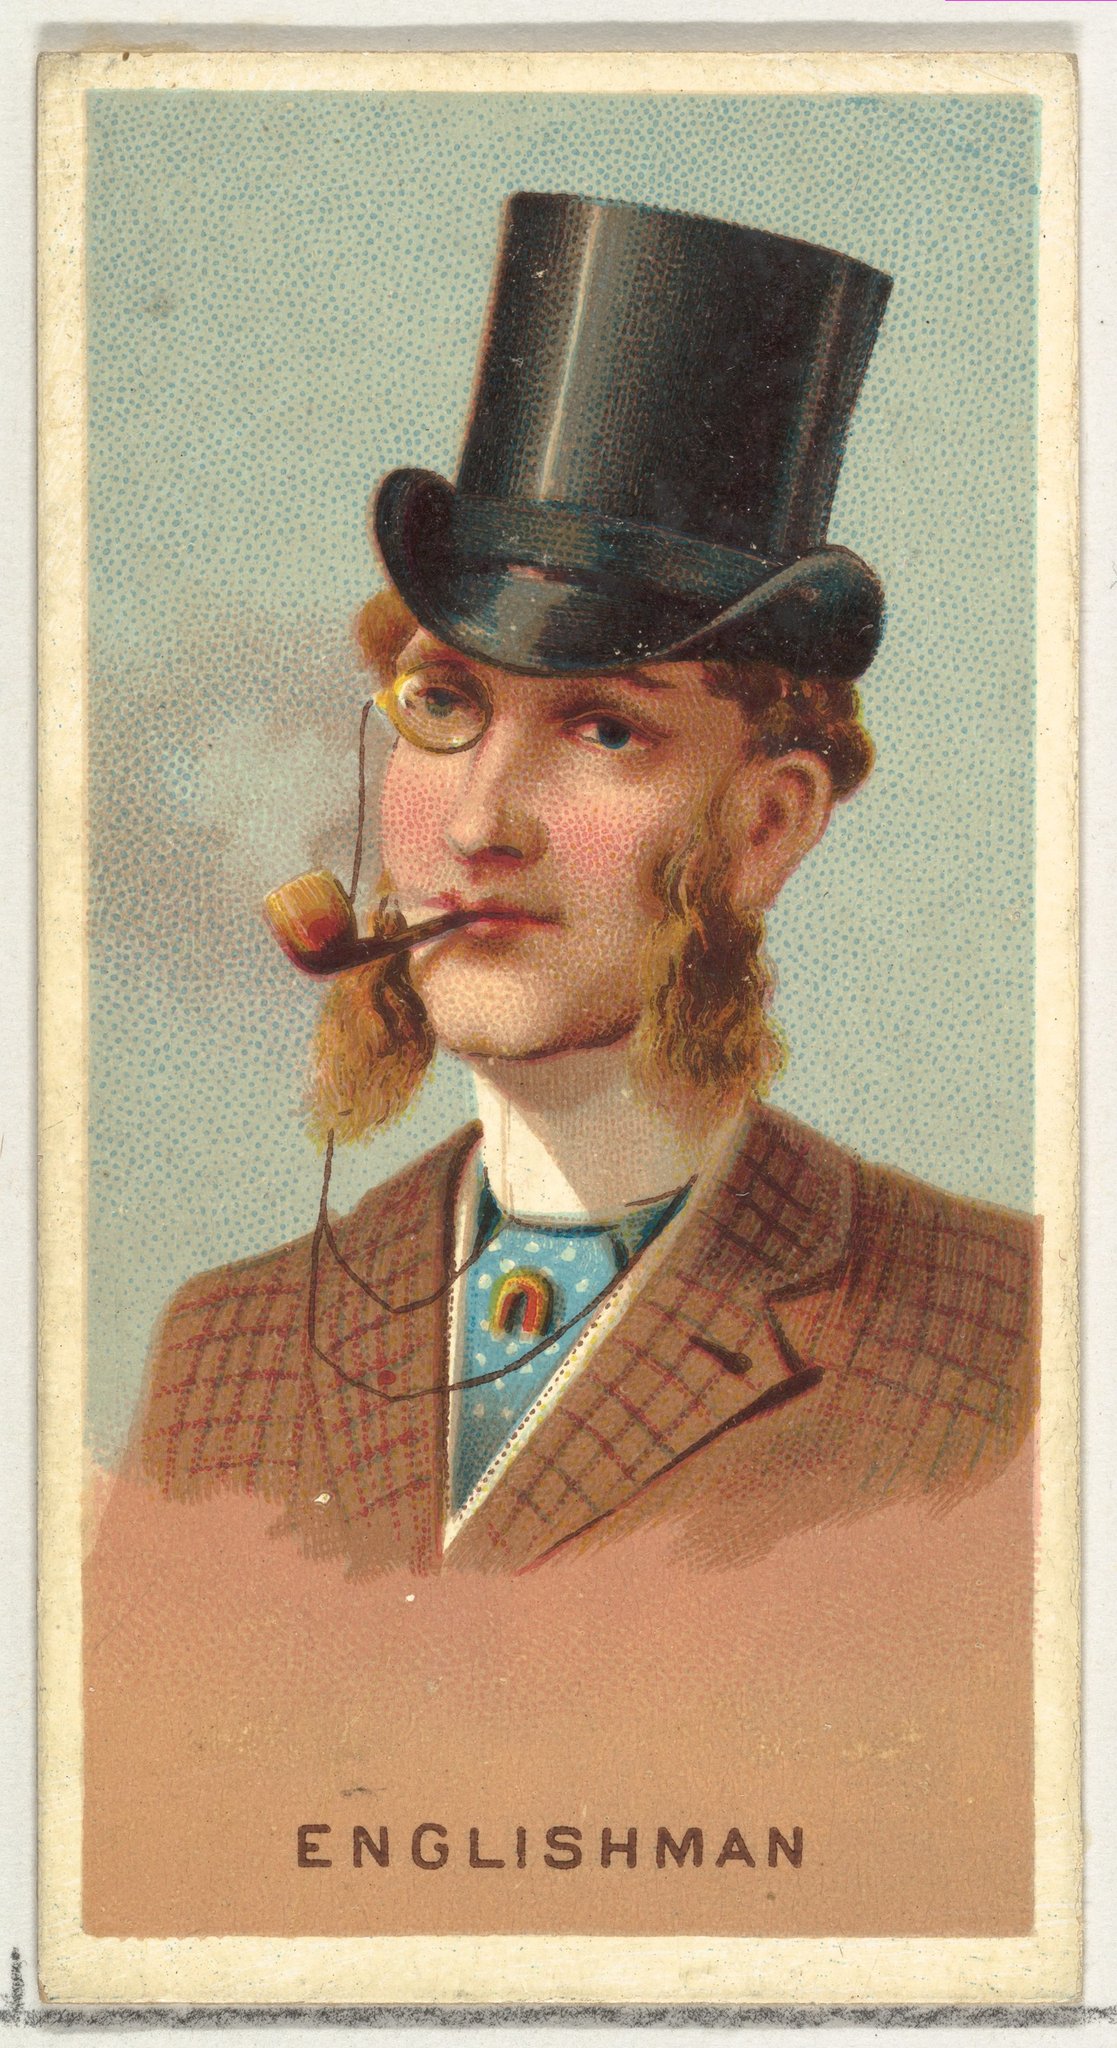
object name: print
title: Englishman, from World's Smokers series (N33) for Allen & Ginter Cigarettes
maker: allen & ginter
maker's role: publisher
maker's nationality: american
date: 1888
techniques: color lithograph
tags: men,smoking